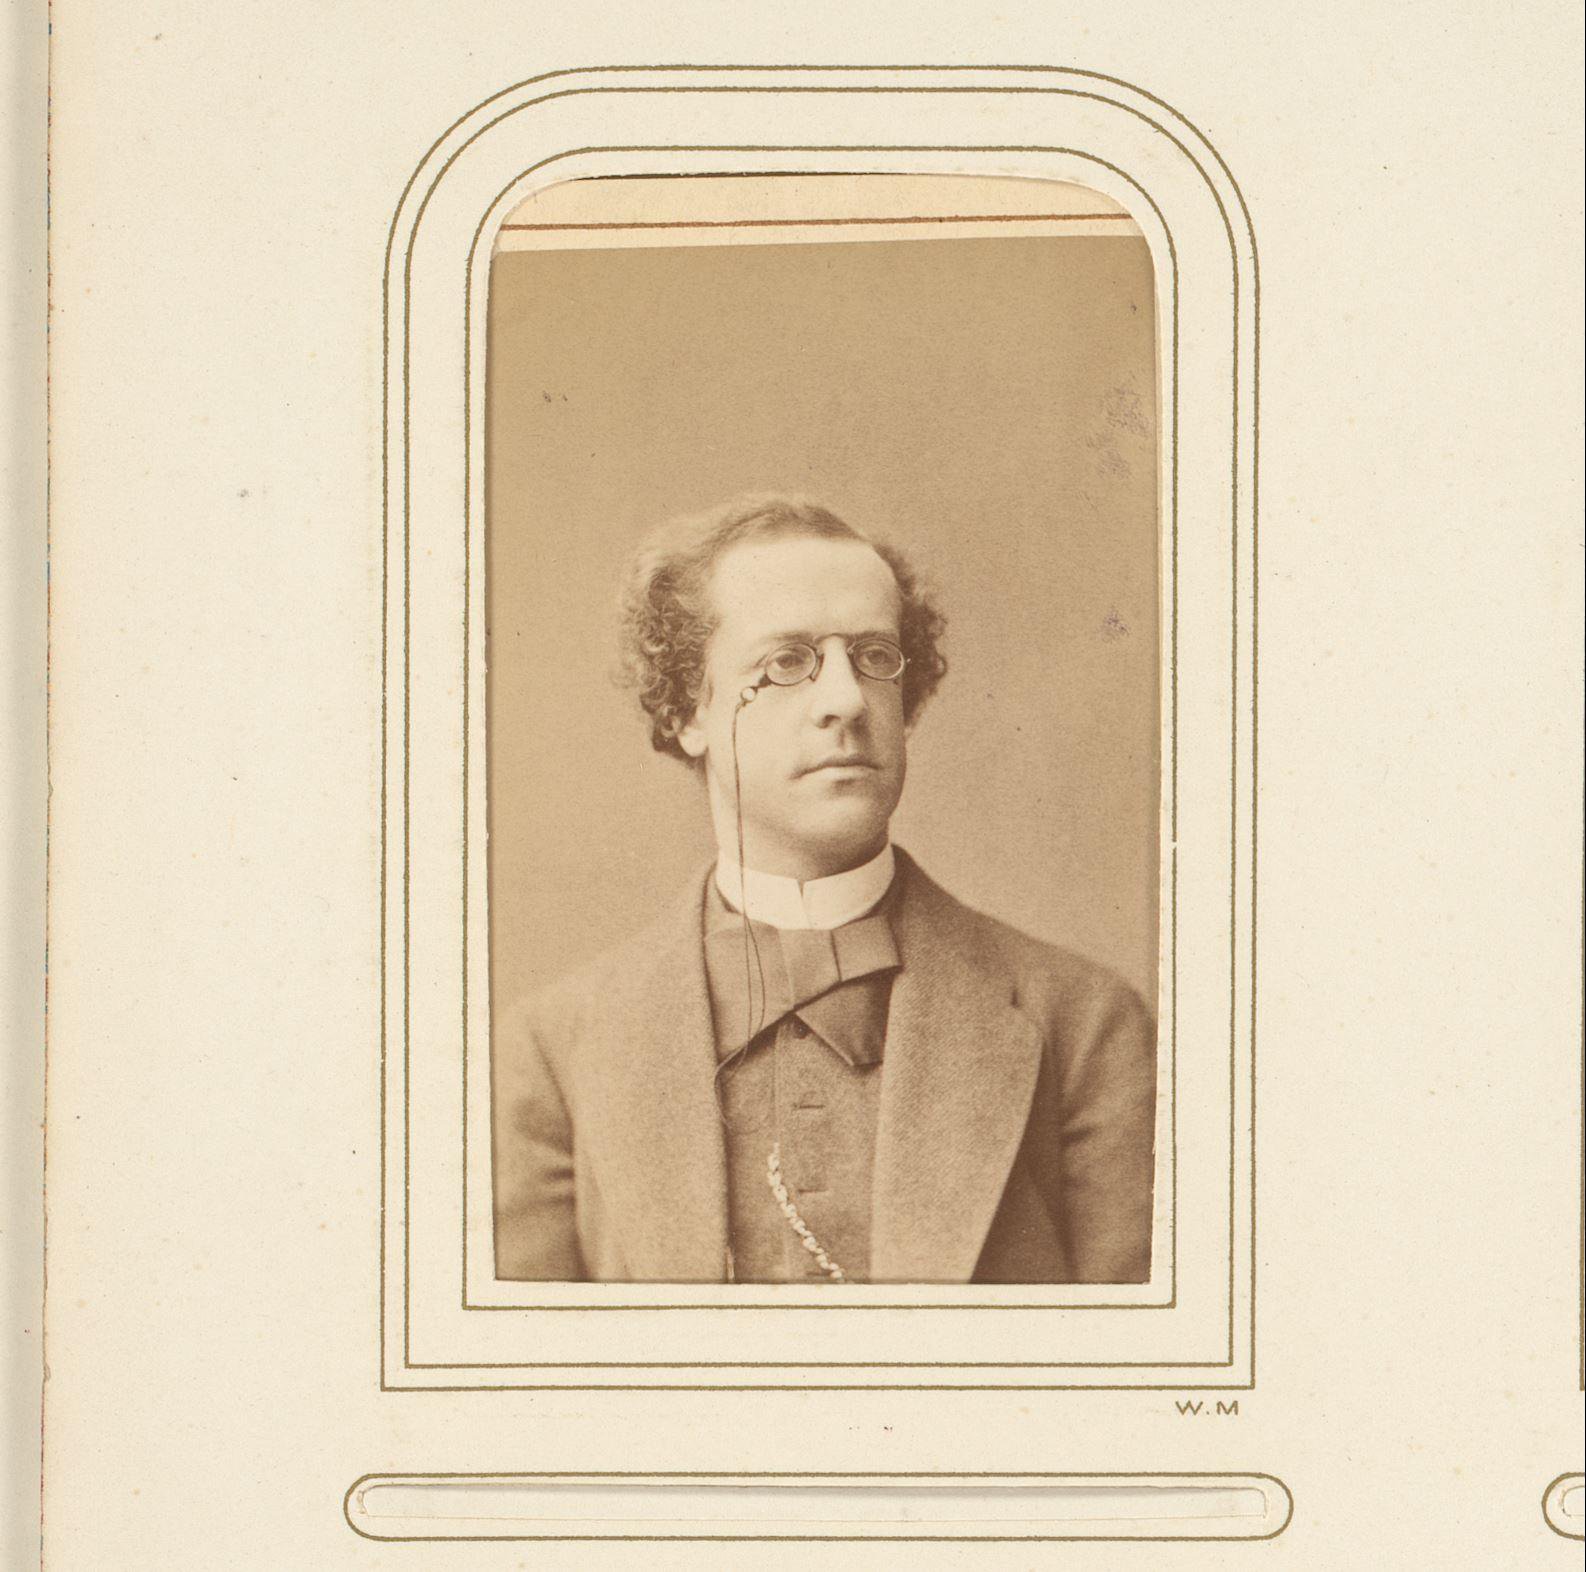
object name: photograph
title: Portret van Per Janzon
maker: gösta florman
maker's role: fotograaf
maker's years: 1831-1900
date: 1862-1875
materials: cardboard, photographic support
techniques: albumen print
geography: stockholm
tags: historical persons, portrait of opera-singer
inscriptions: annotation: ‘Pelle Janzon/ 1844 - 1889’, inscription: ‘Gösta Florman/ STOCKHOLM/ 28 A.Regeringsgatan 28 A.’